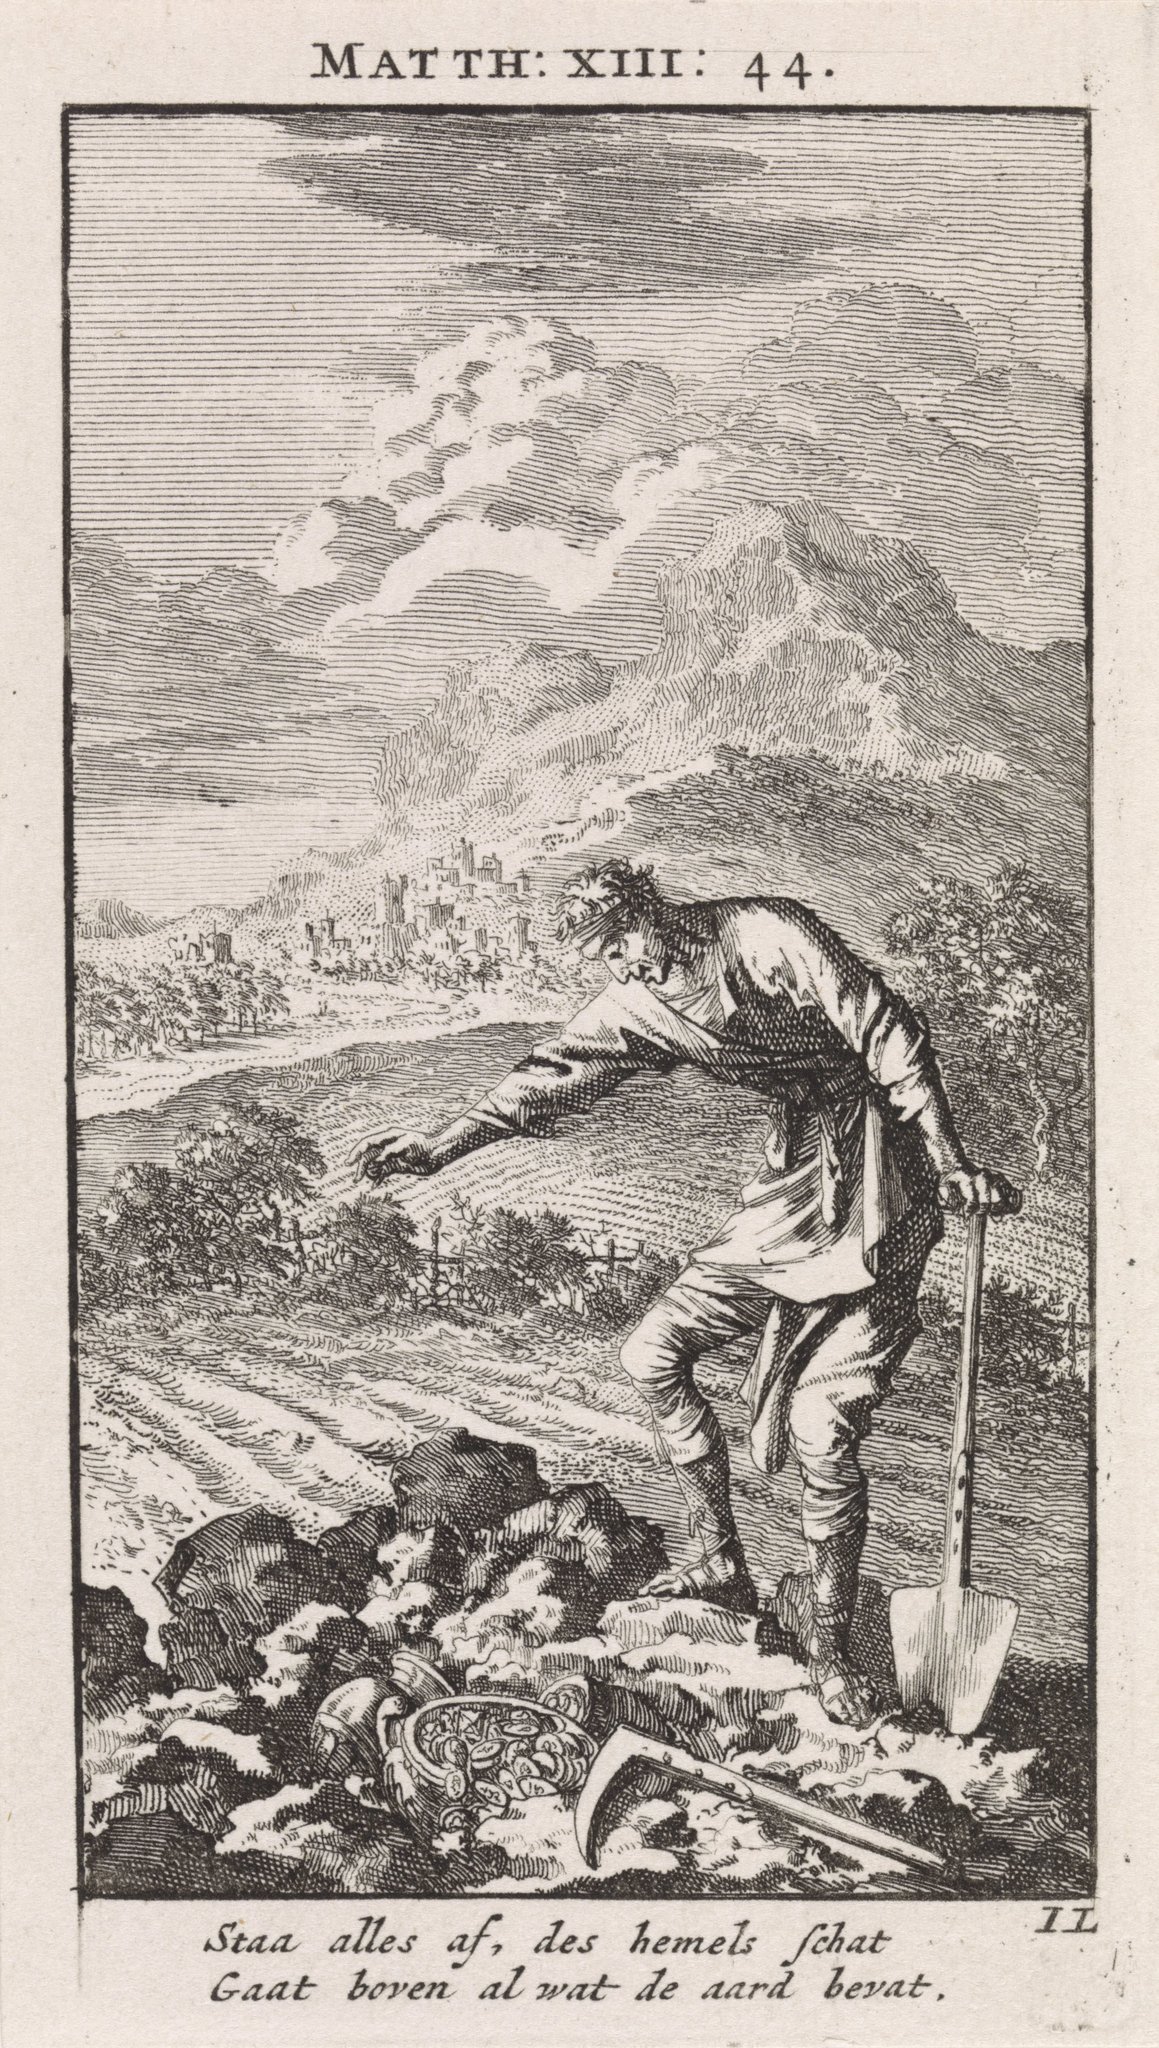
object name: print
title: Gelijkenis van de schat in de akker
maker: jan luyken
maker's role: draughtsman, print maker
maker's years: 1649-1712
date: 1712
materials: paper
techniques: etching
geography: amsterdam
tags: 'the kingdom of heaven is like treasure hidden in a field' ~ proverbial saying of christ (matthew 13:44)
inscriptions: collector's mark: Lugt 2228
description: Illustratie voor: Luyken, Jan. Bybel printen. Amsterdam: Pieter Arentsz. II (wed.) en Cornelis van der Sys, 1712, p. 19.